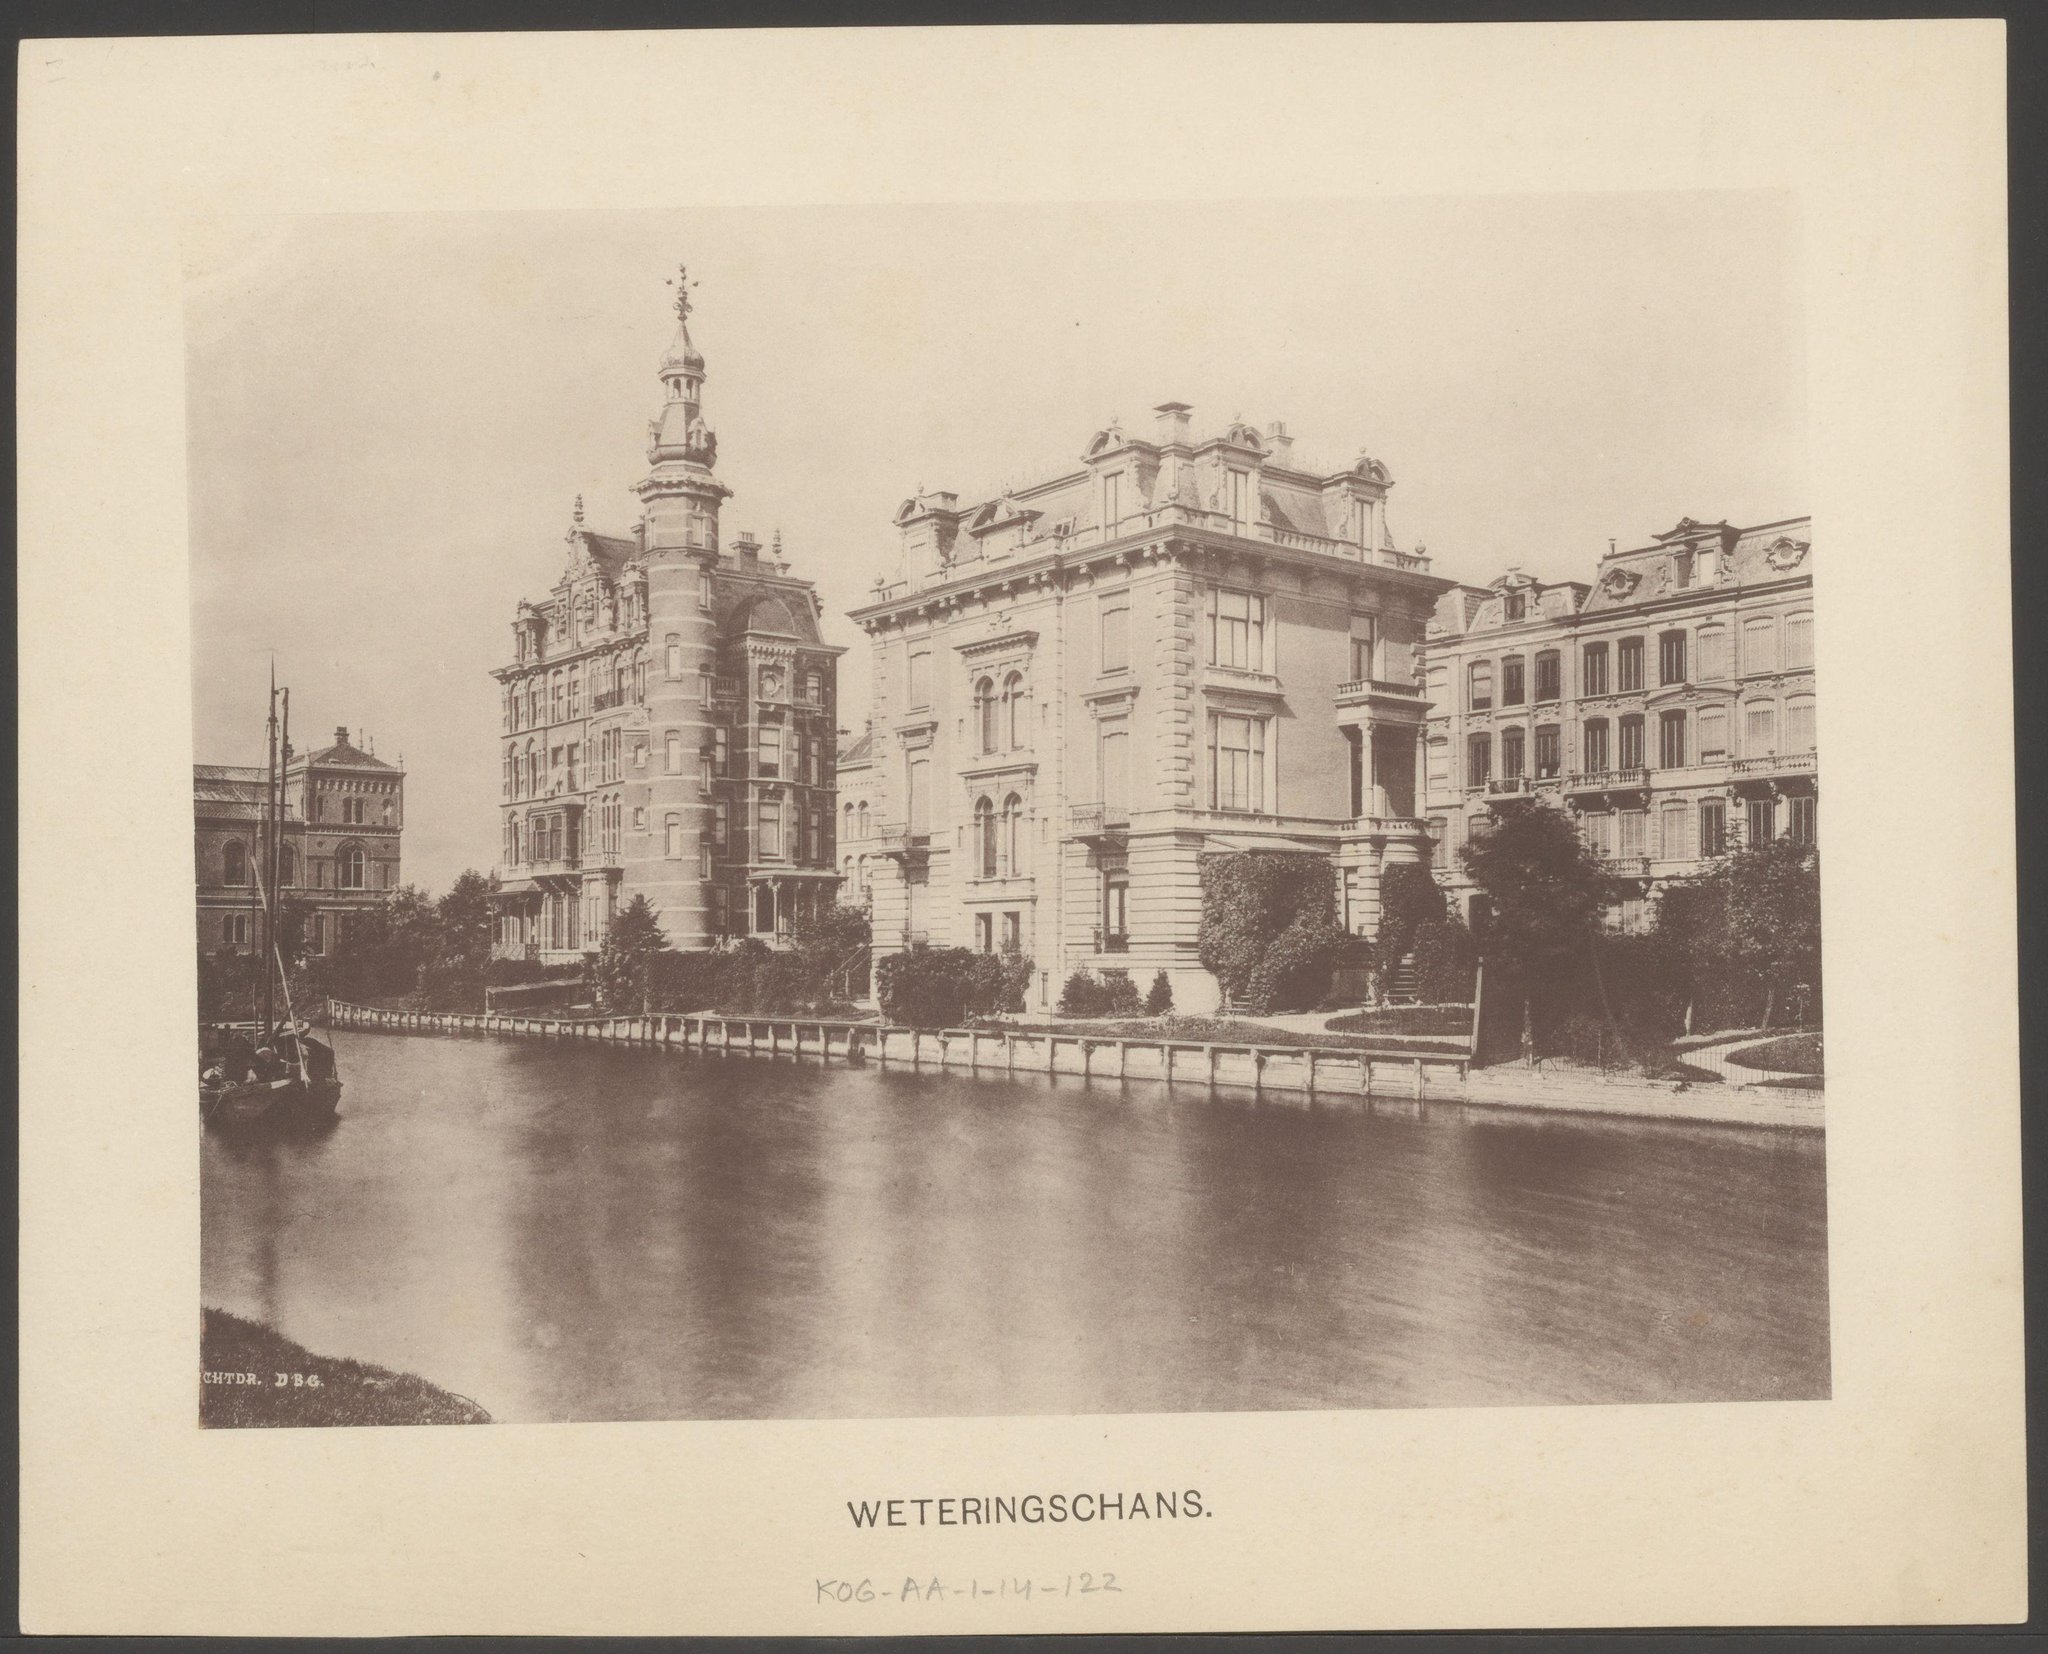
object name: photomechanical print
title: Gezicht op de Weteringschans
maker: Anonymous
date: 1875-1930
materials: cardboard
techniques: photograph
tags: city-view in general; 'veduta', canal, façade (of house or building)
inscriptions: inscription: ‘Legaat Joh. M. Coffeng. 1966’, collector's mark: ‘14C122’ Lugt 1641b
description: Onderwerpsrubriek binnen de Atlas Amsterdam: Waal (Kromme en Oude), Walenpleintje, Warmoesgracht, Warmoesstraat, Waterlooplein, Westerdoksdijk, Westermarkt, Weteringschans, Willemspark, Willemsstraat, Wittenburg, Wittenkade (de), Wittenstraat (de).